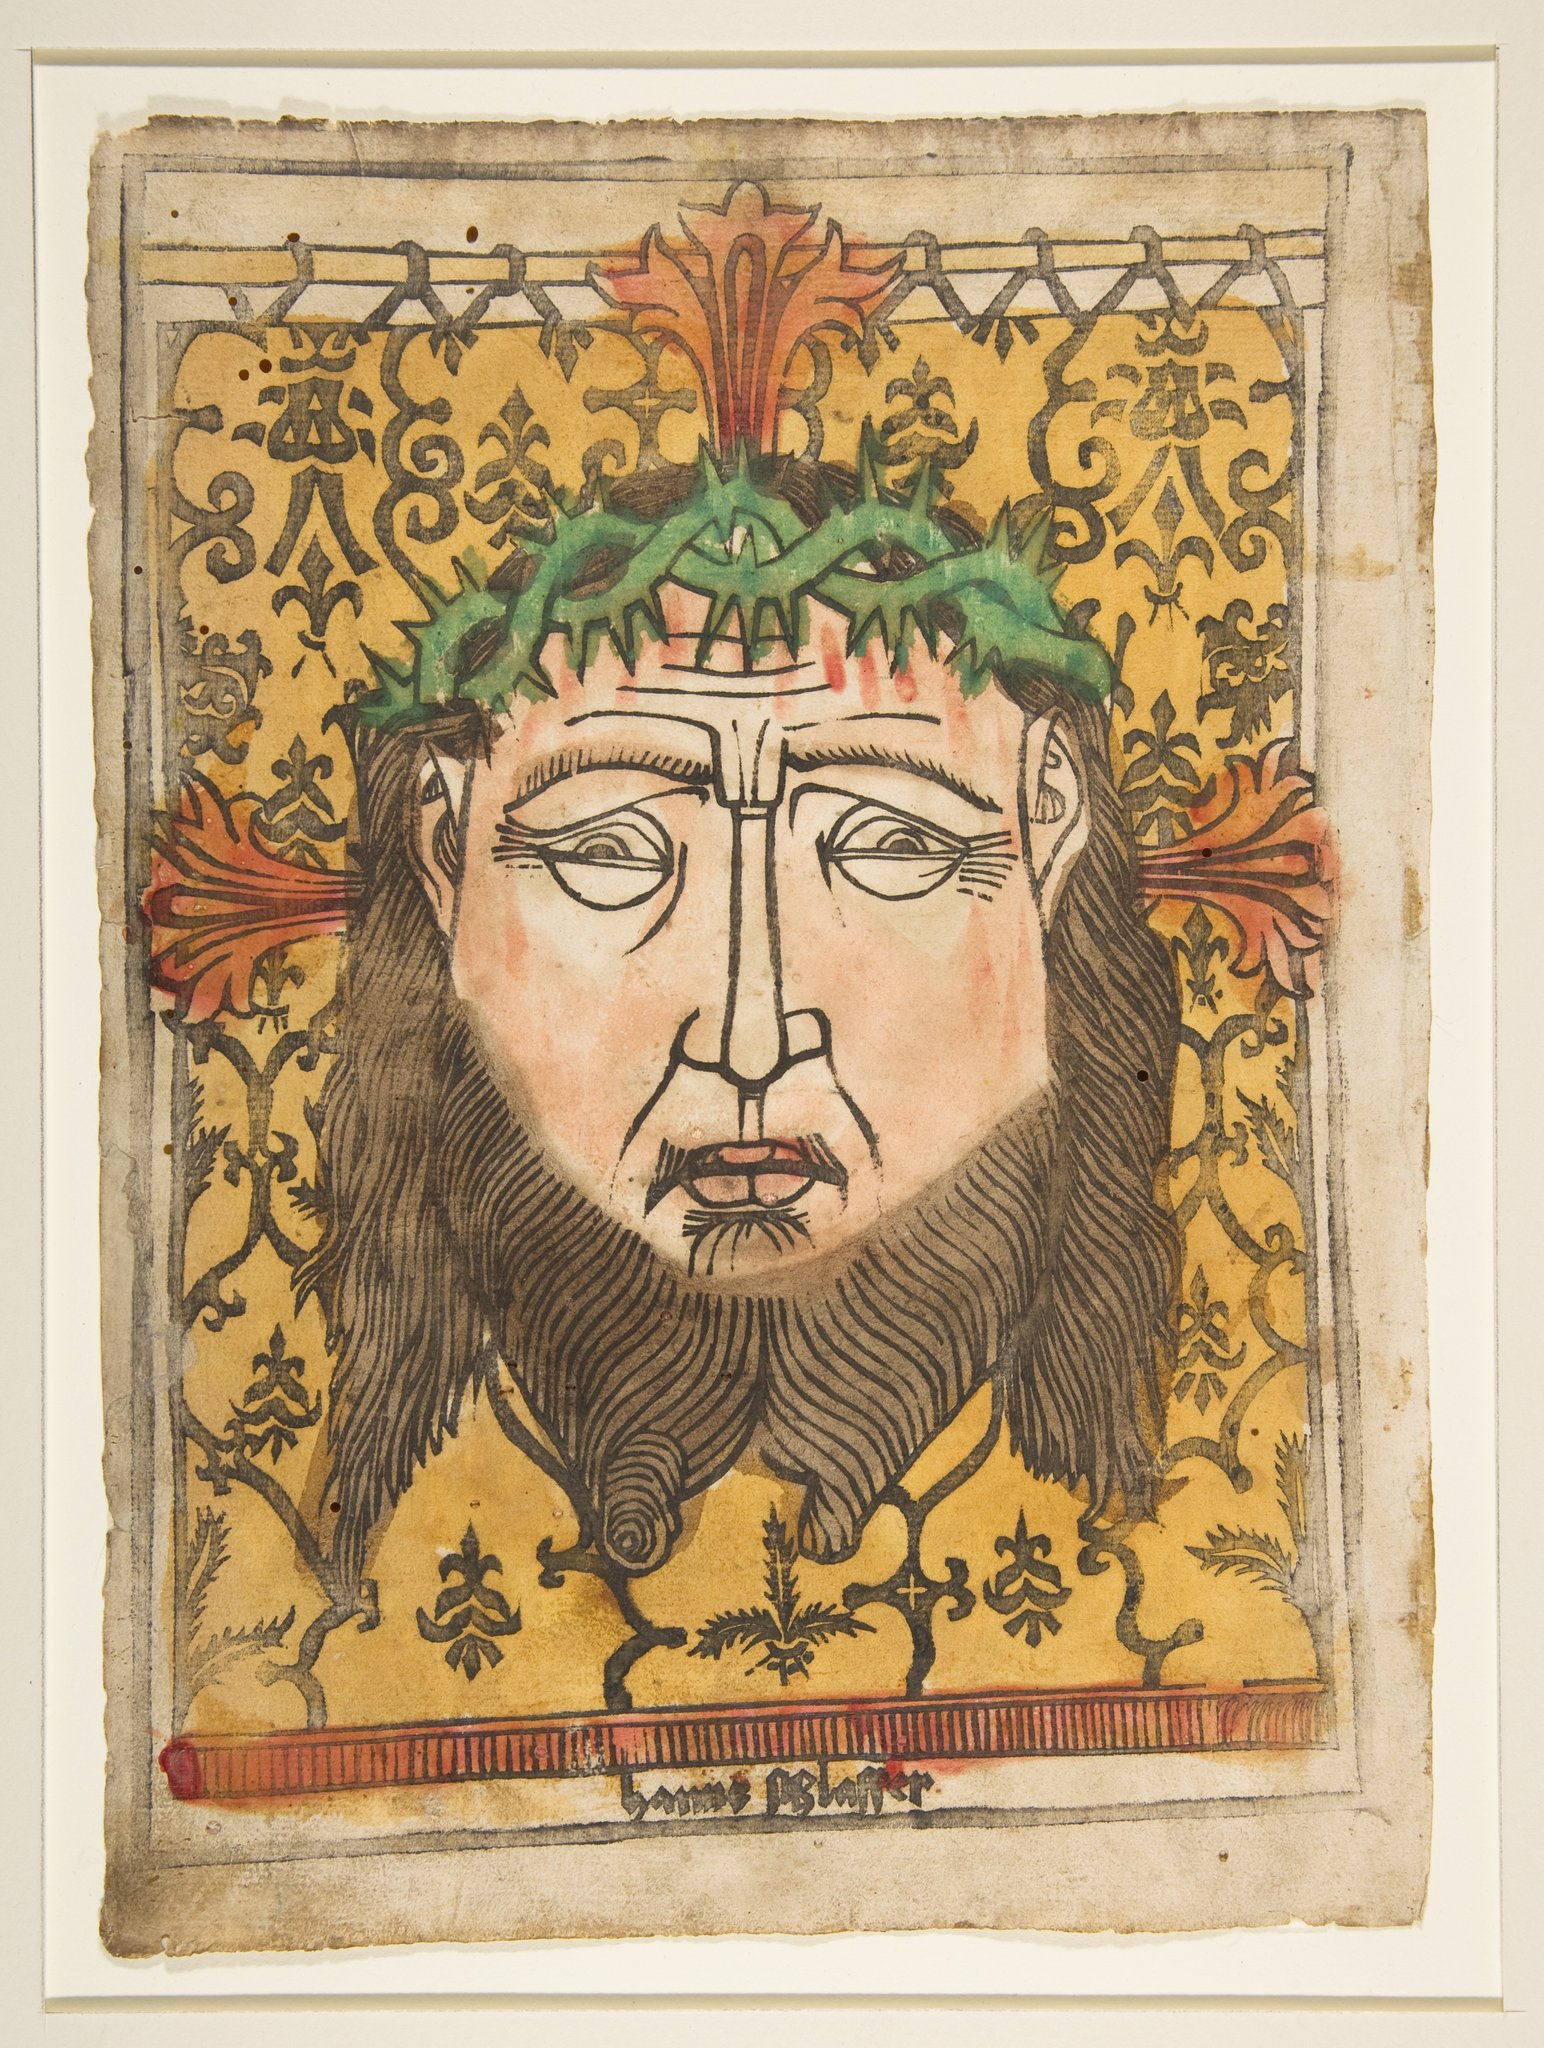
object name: print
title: The Sudarium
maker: hans schlaffer of ulm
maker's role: artist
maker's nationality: german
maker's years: 1470-1475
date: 1470-1475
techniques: hand coloring, woodcut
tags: christ